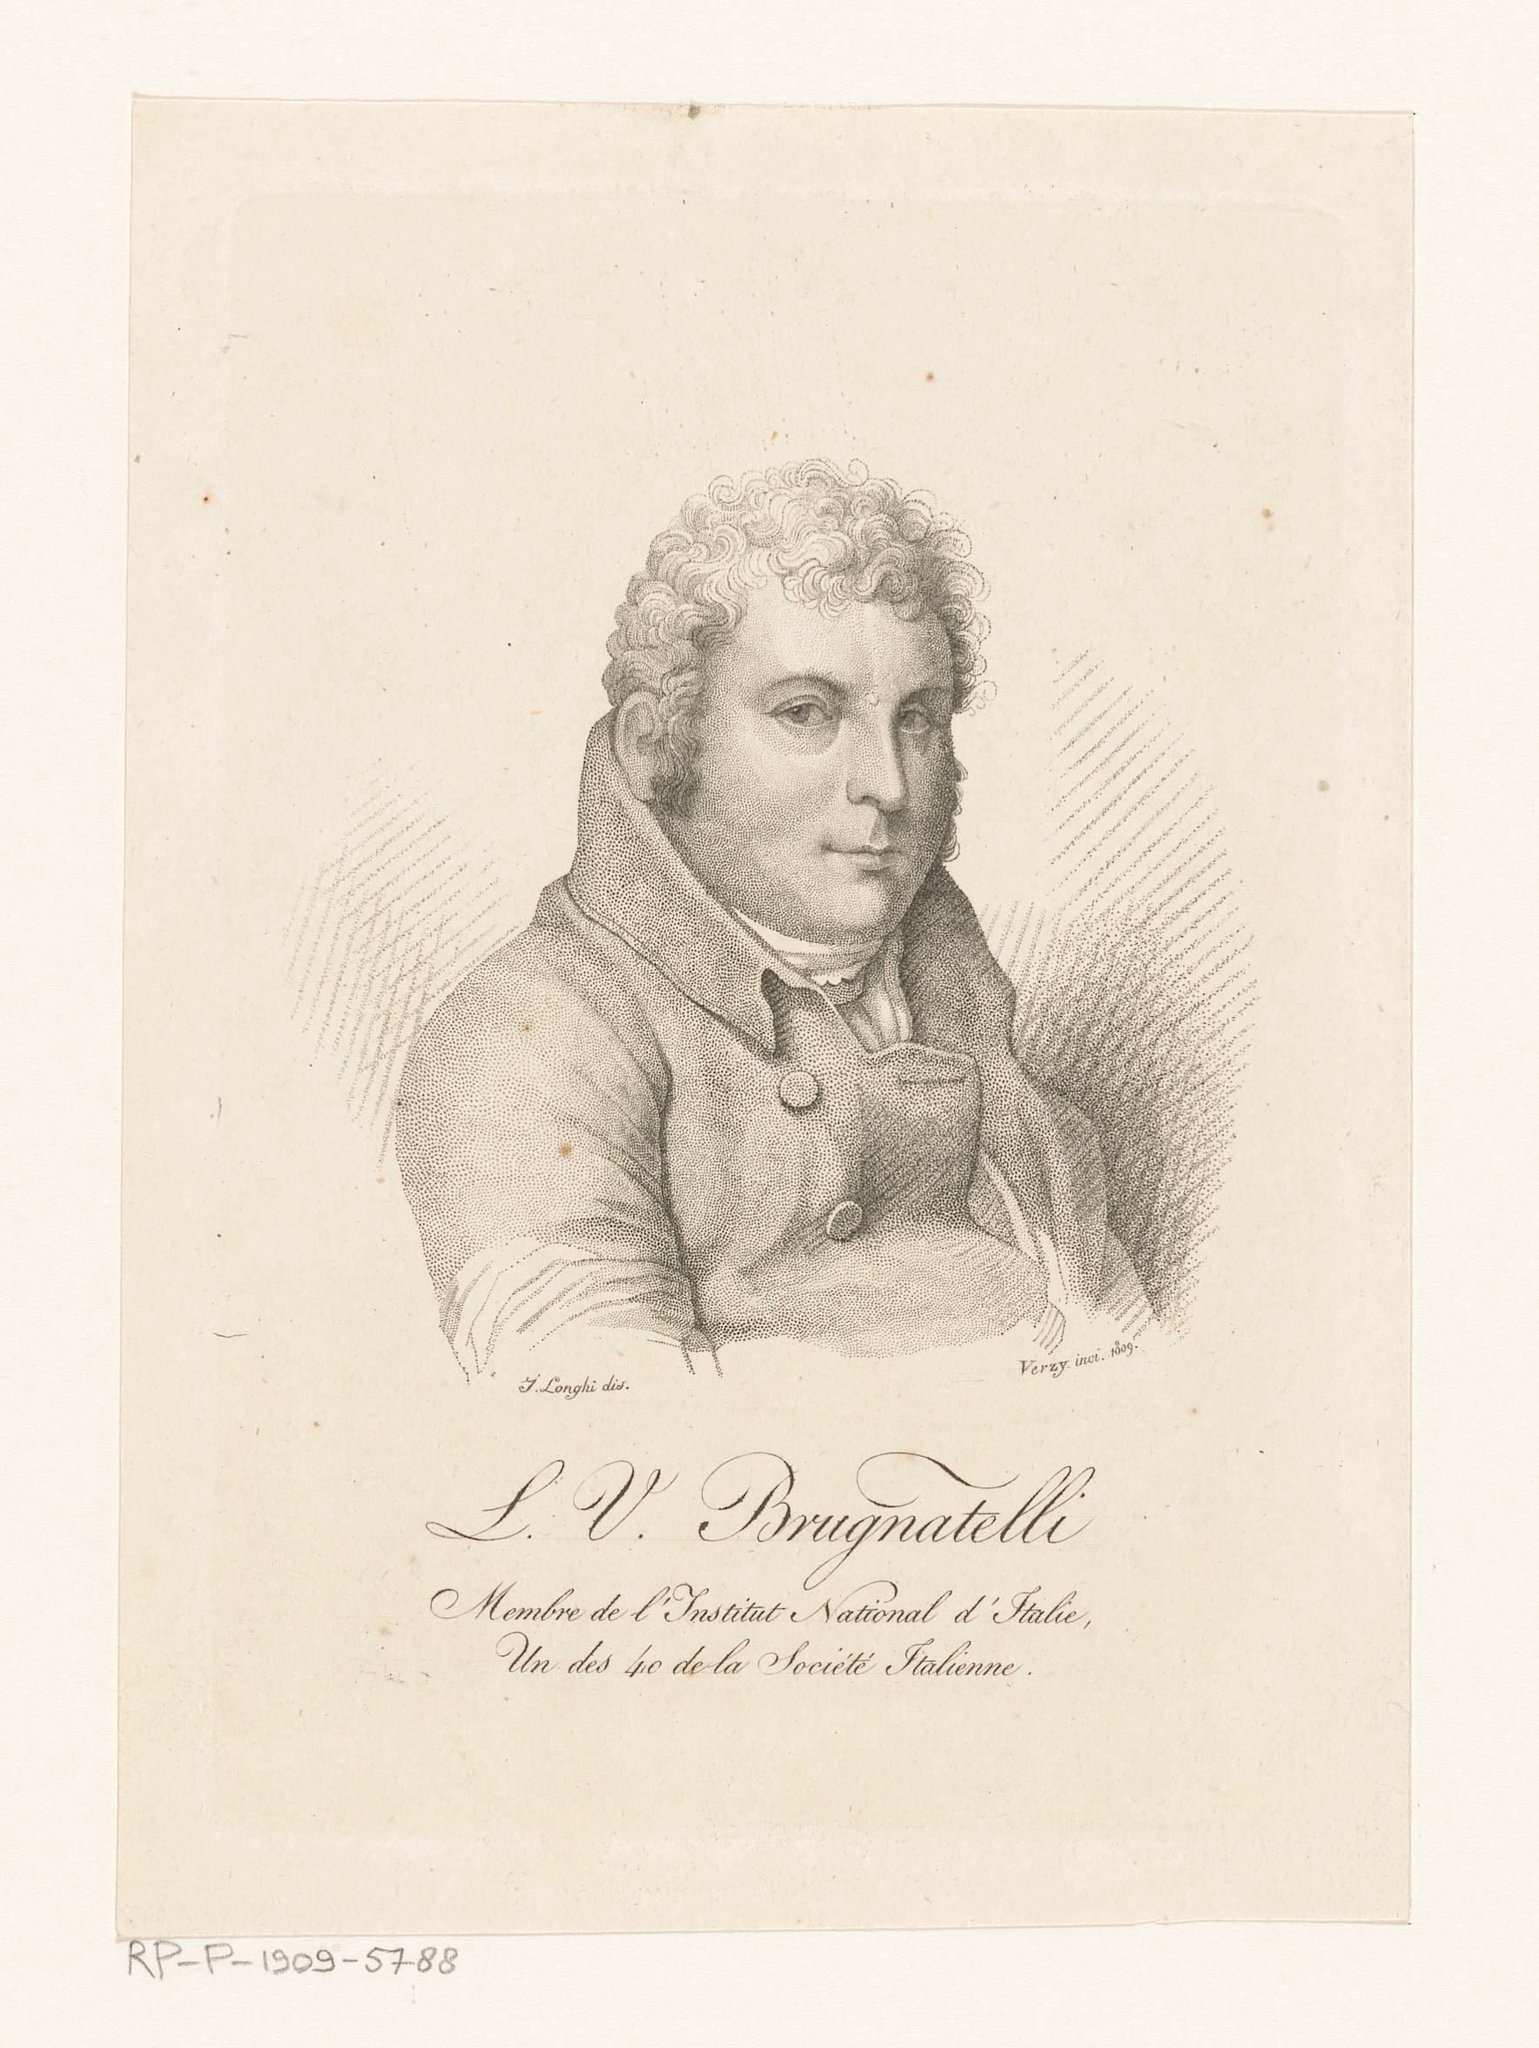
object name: print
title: Portret van Luigi Valentino Brugnatelli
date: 1809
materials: paper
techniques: engraving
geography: france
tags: historical persons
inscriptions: collector's mark: Lugt 2228